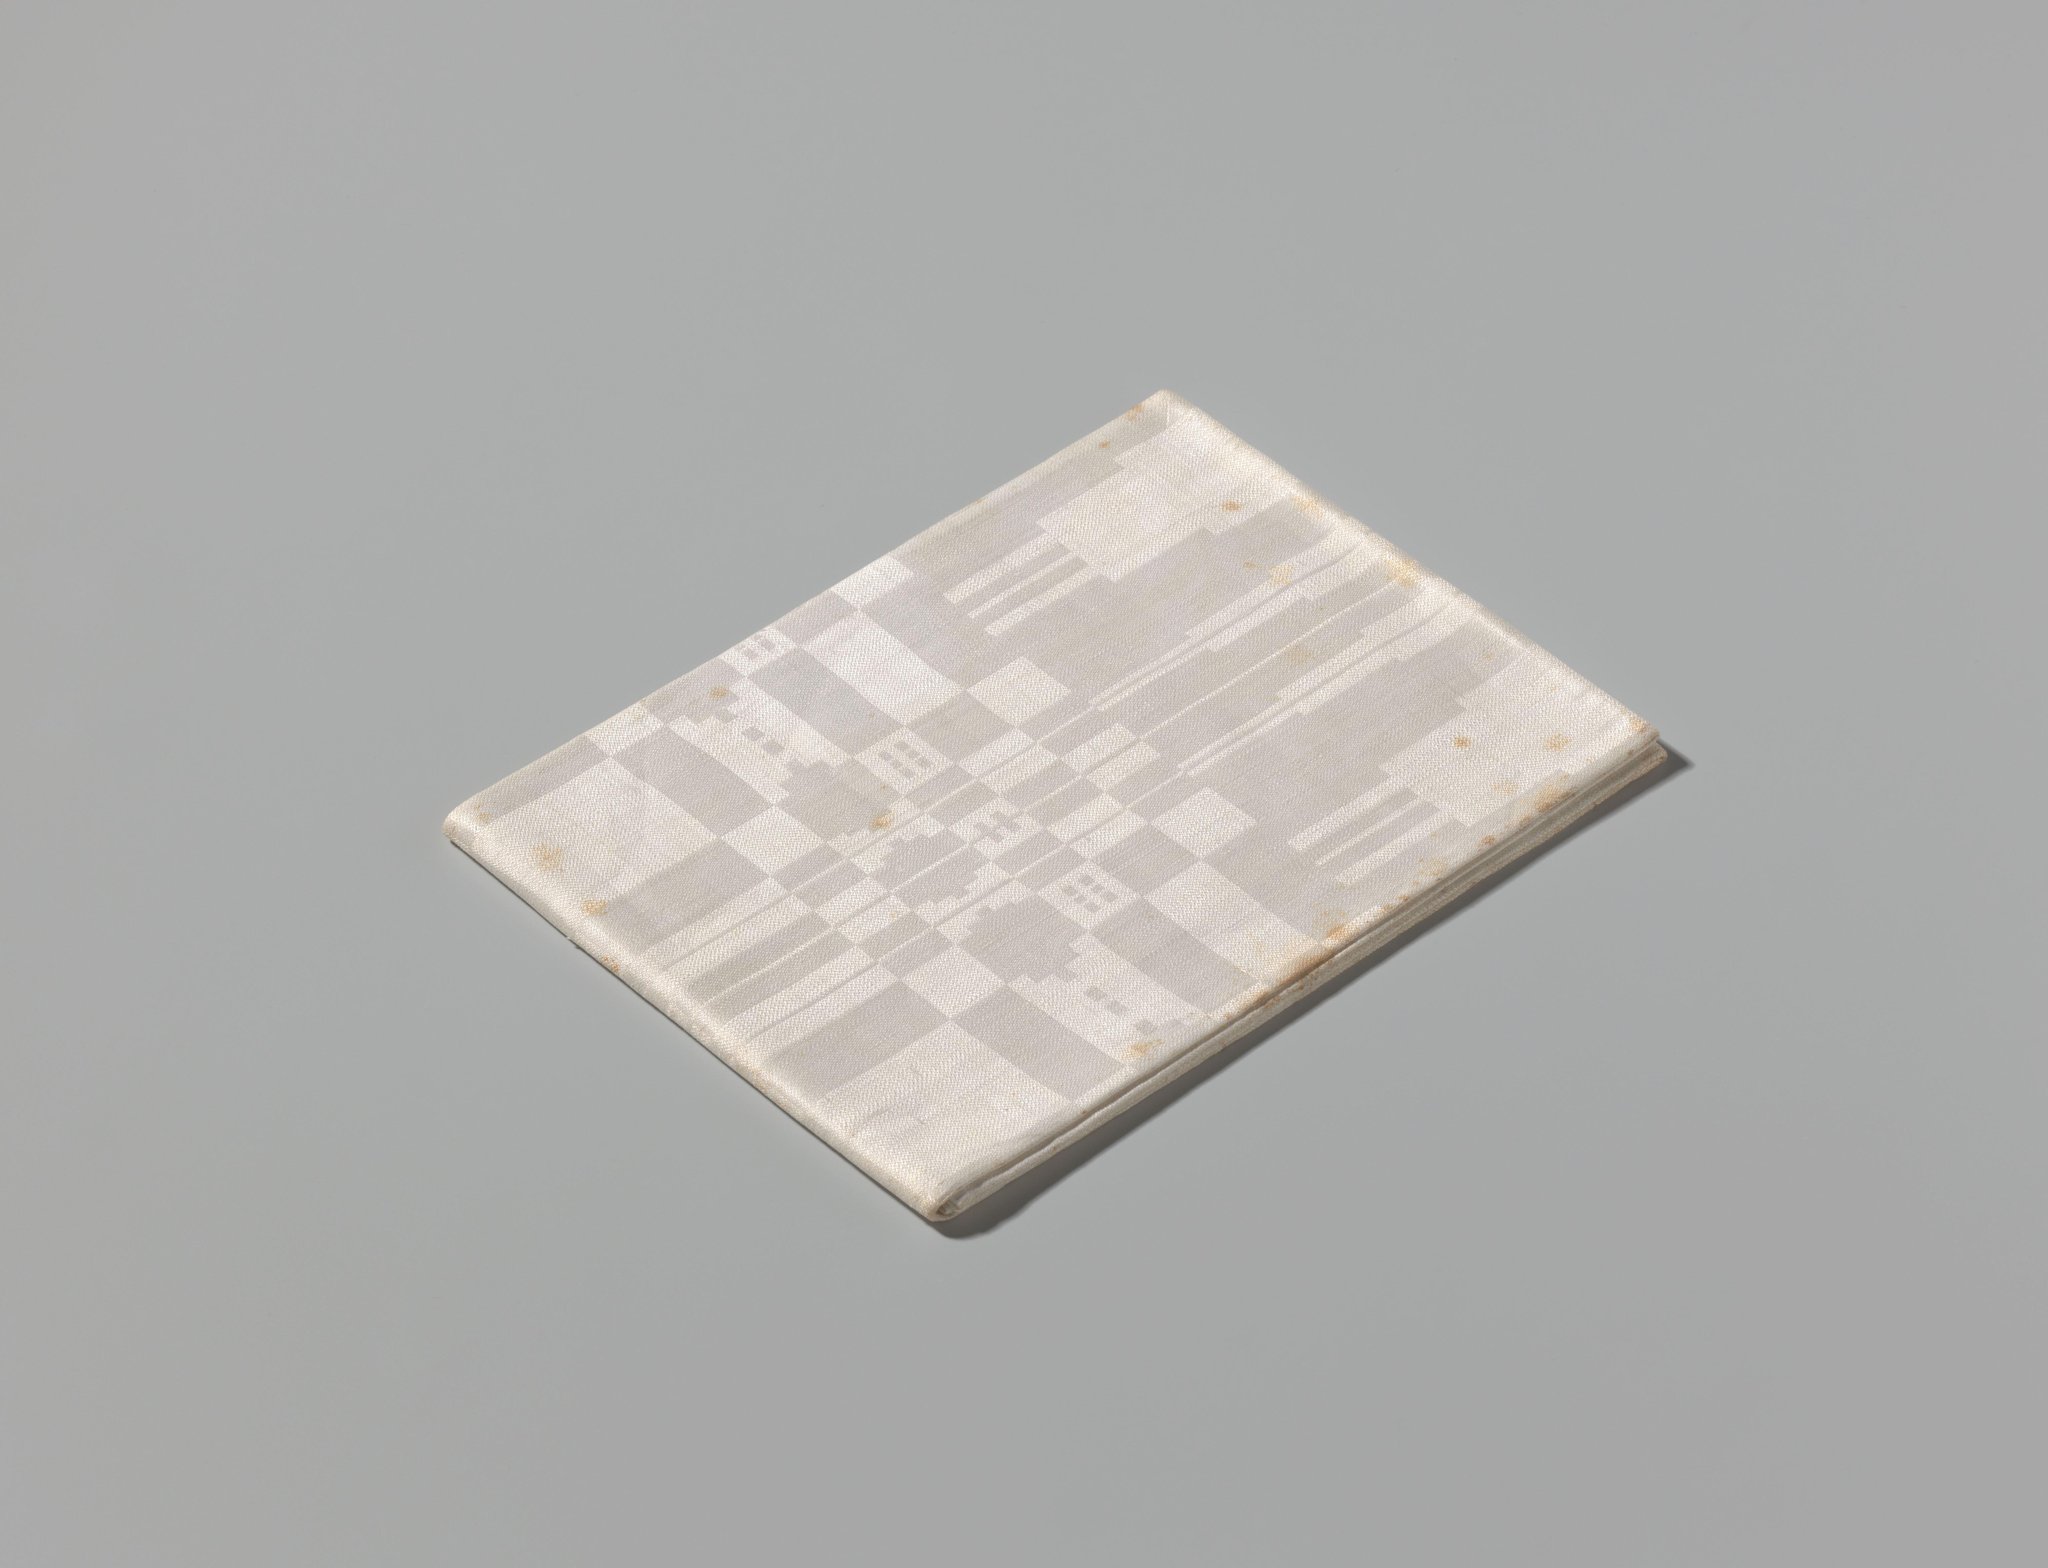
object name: napkin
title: Pellen in patroon 'torenwerk'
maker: Anonymous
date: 1725-1769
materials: linen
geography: netherlands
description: Servet van wit linnen met een pellenpatroon in kruiskeper z.g. 'torenwerk', merk ARVG 39.